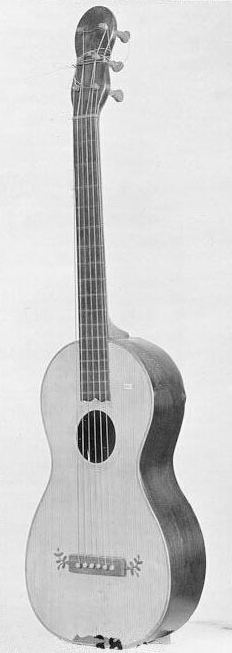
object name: guitar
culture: european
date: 1801-1900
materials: brass, wood